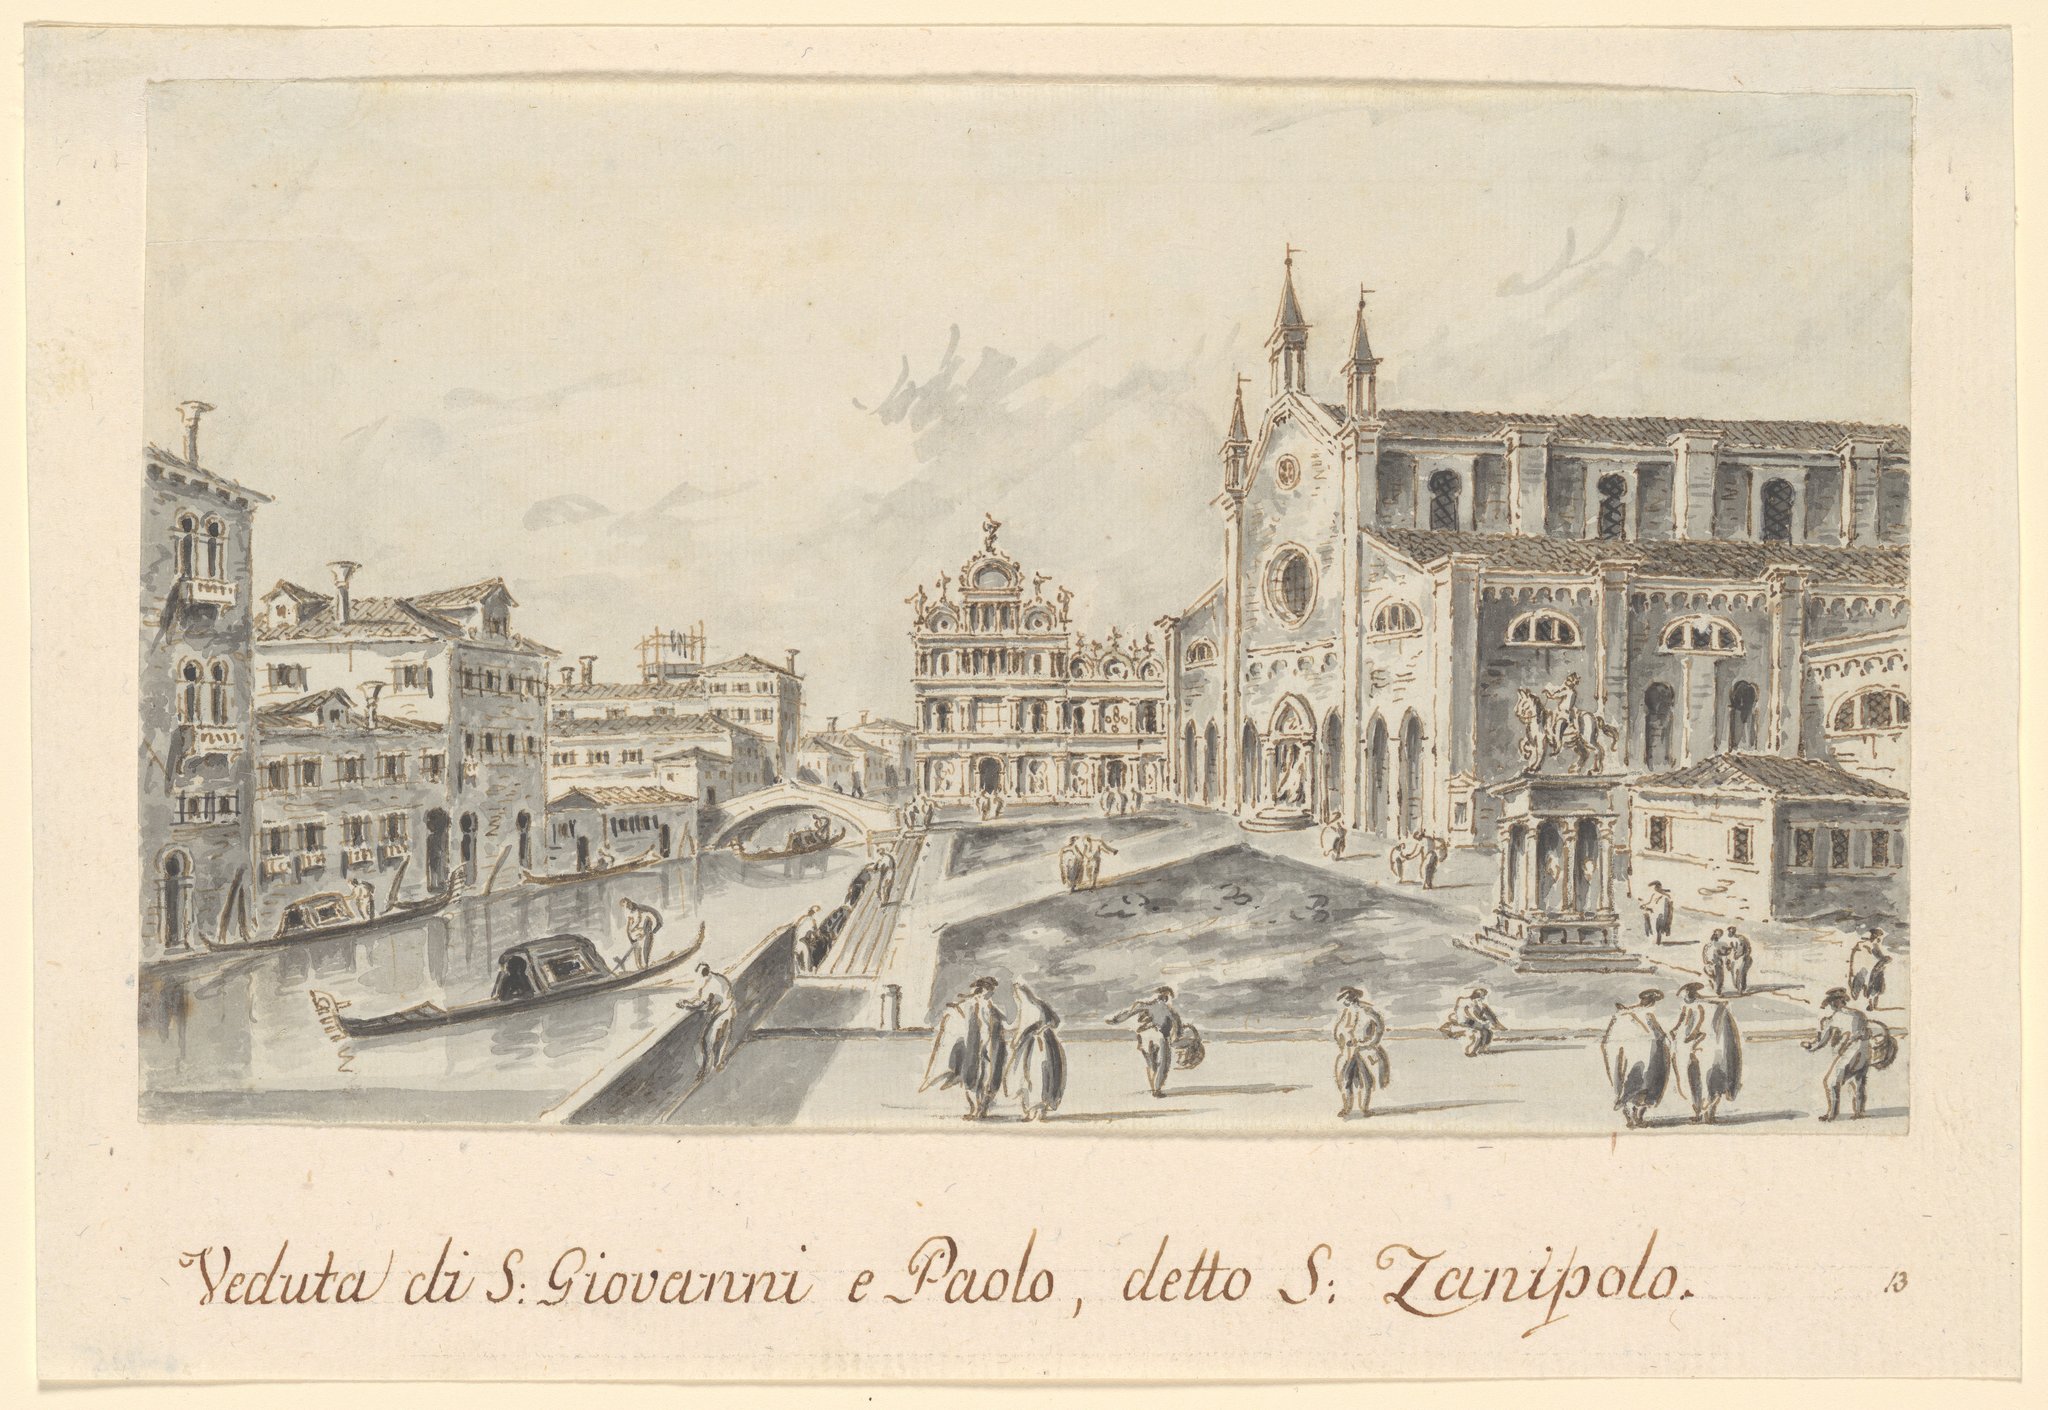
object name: drawing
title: Campo Santi Giovanni e Paolo, Looking Toward the Scuola di San Marco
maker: giacomo guardi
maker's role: artist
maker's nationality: italian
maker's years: 1764-1835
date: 1804-1828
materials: ink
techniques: pen, wash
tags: buildings,canals,boats,venice